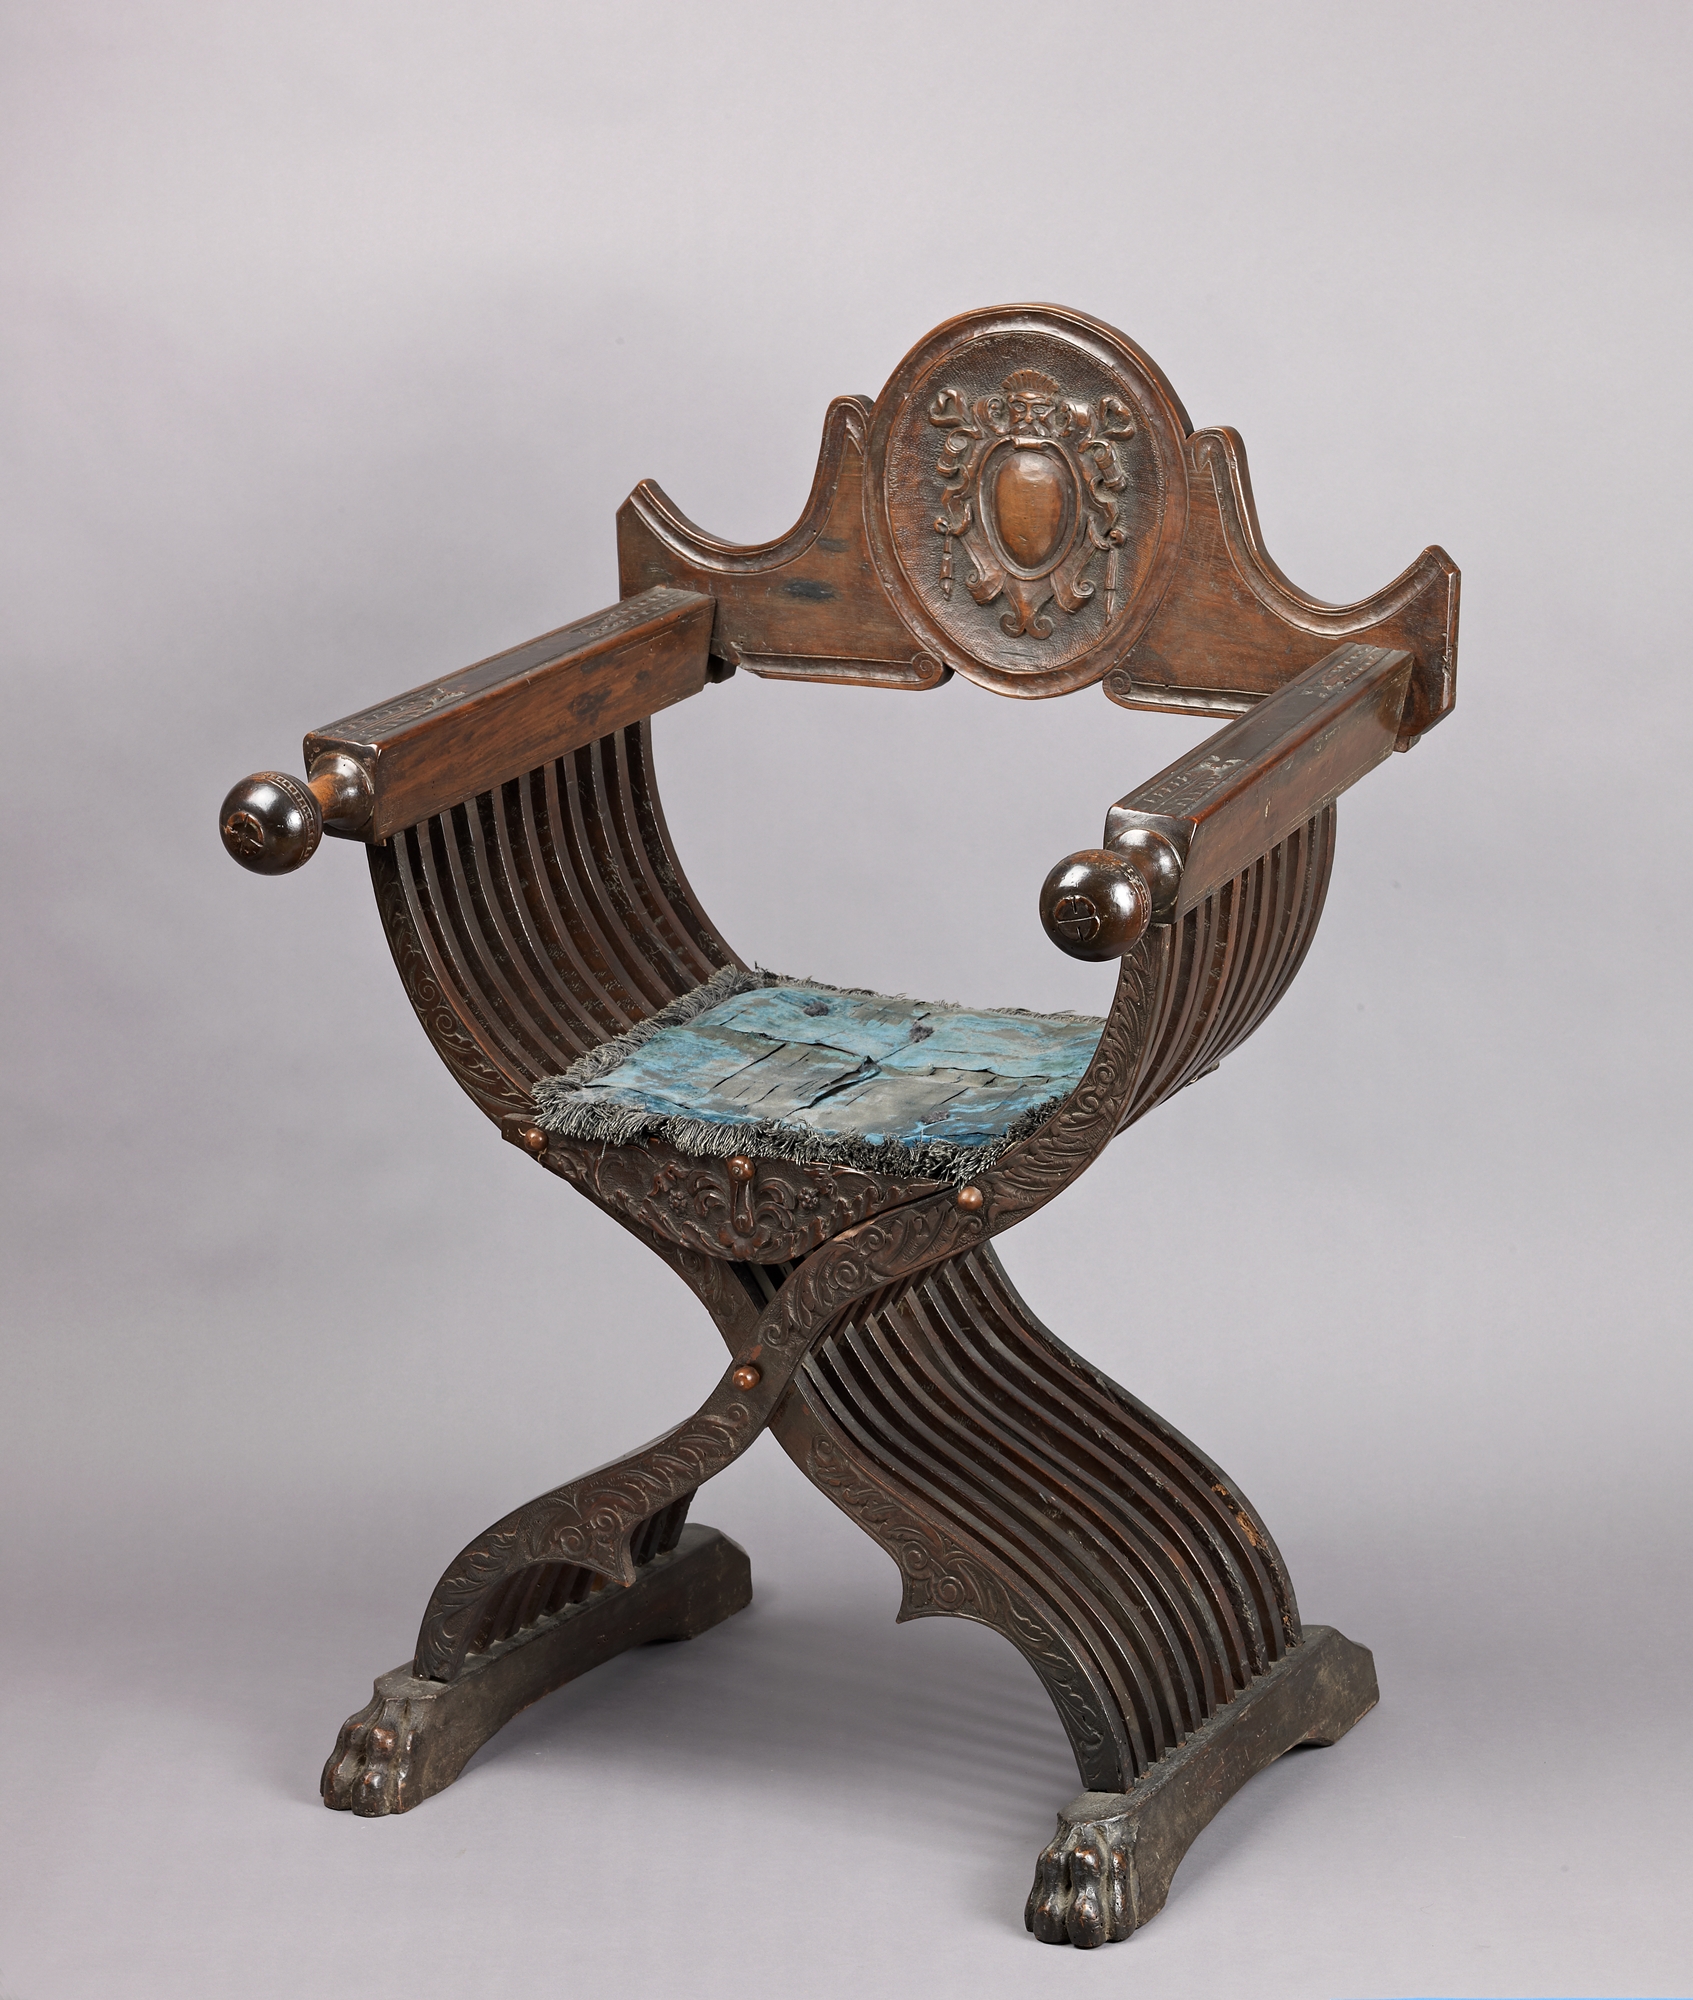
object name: armchair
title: Folding armchair (sedia a Savonarola type)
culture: italian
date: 1401-1500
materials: silk, wood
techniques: carving